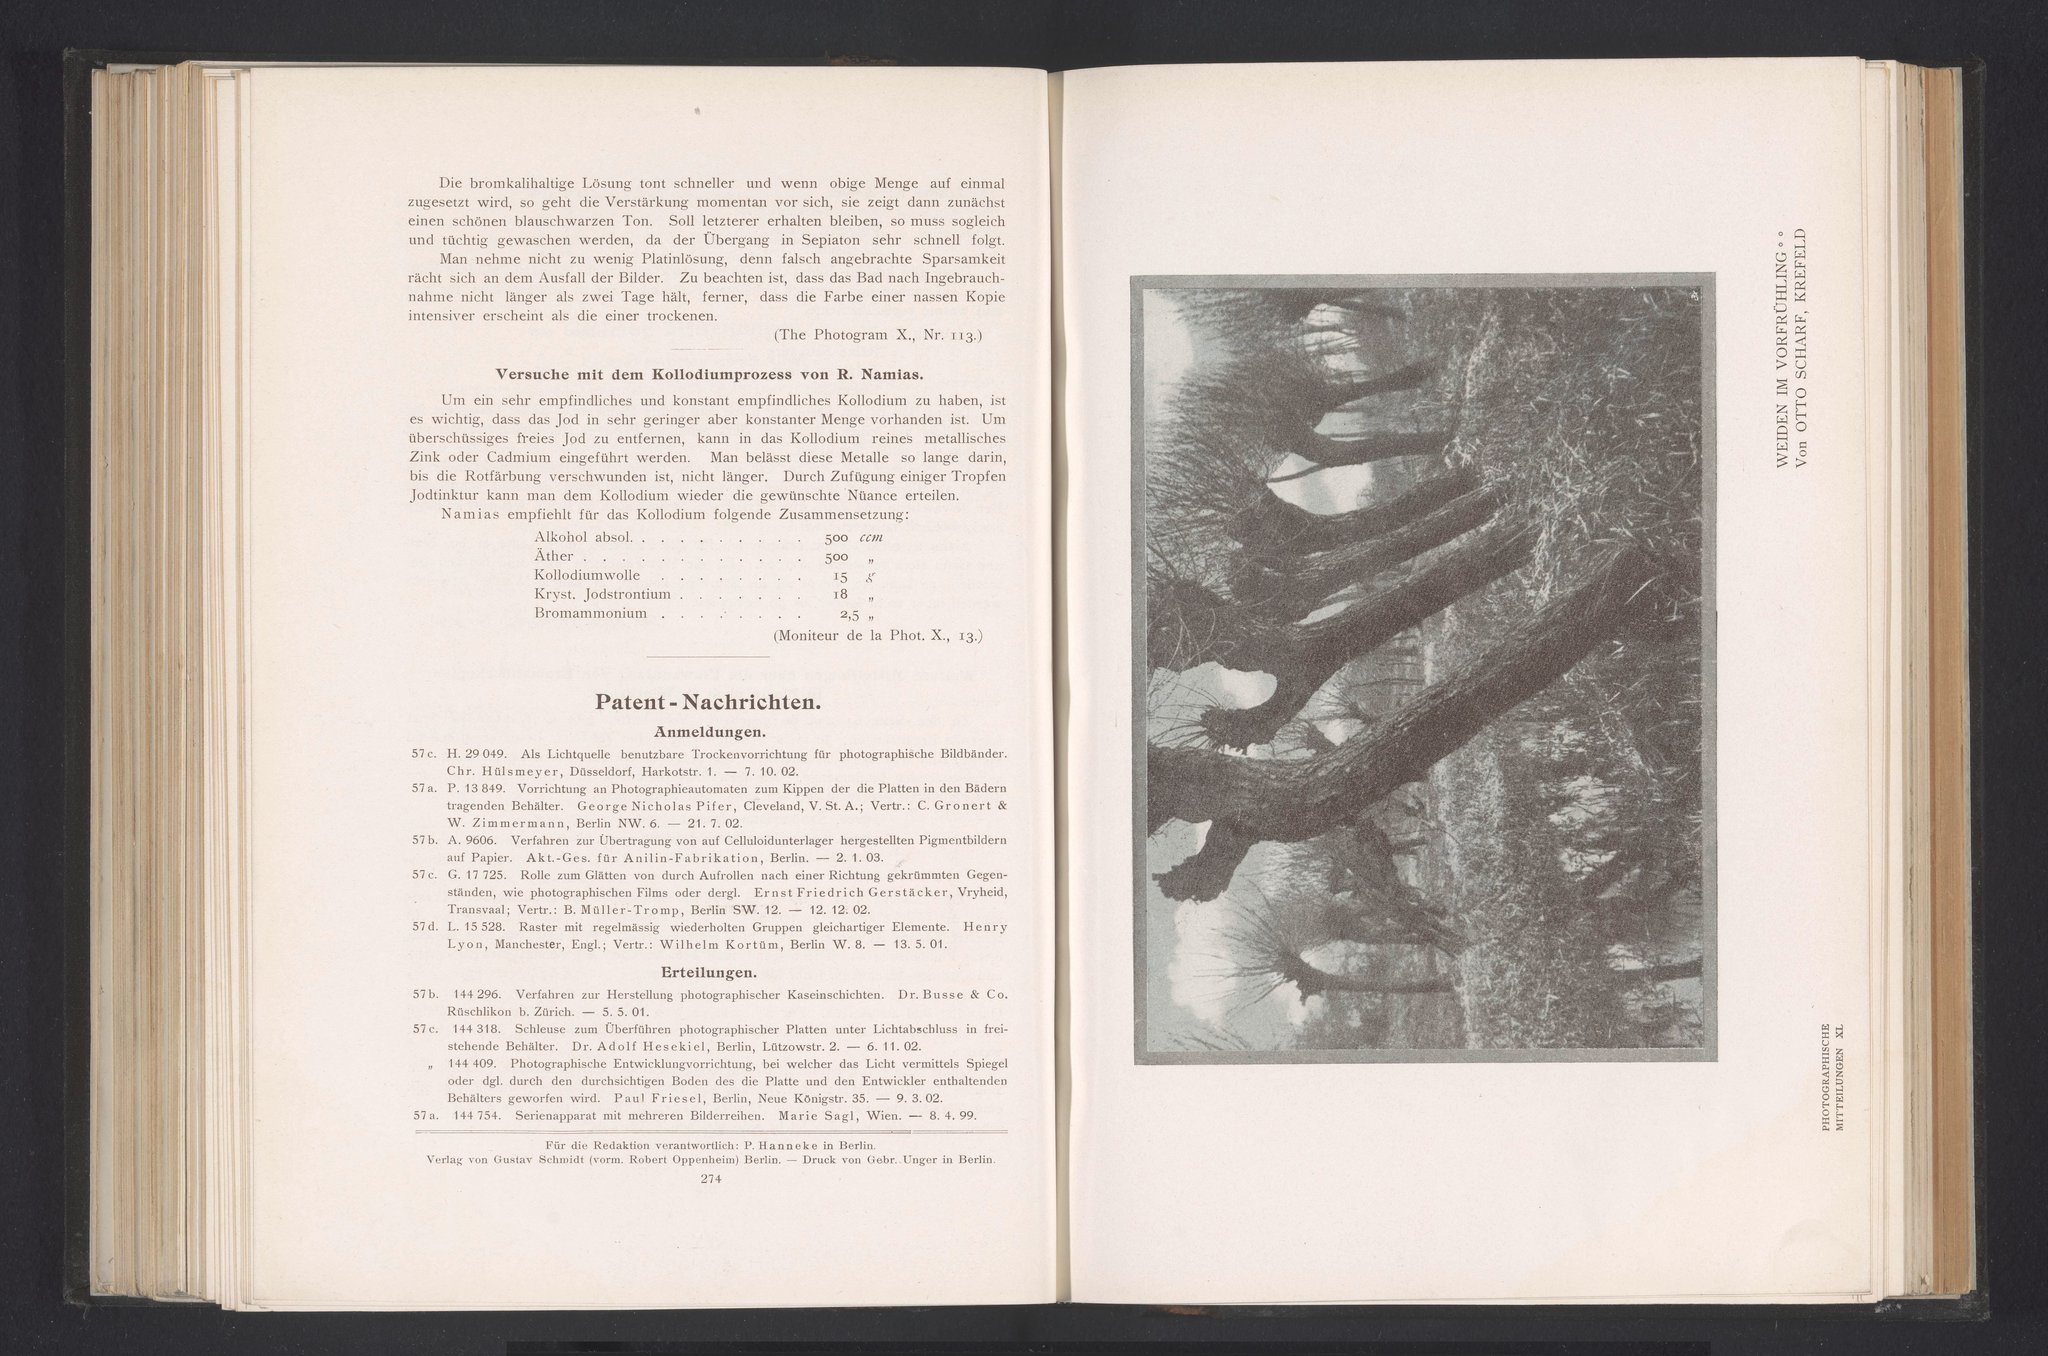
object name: page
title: Weiden im vorfrühling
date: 1898-1903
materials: paper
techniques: autotype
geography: krefeld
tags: landscapes, trees: willow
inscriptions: inscription: ‘Photographische Mitteilungen XL’, monogram: ‘BX’